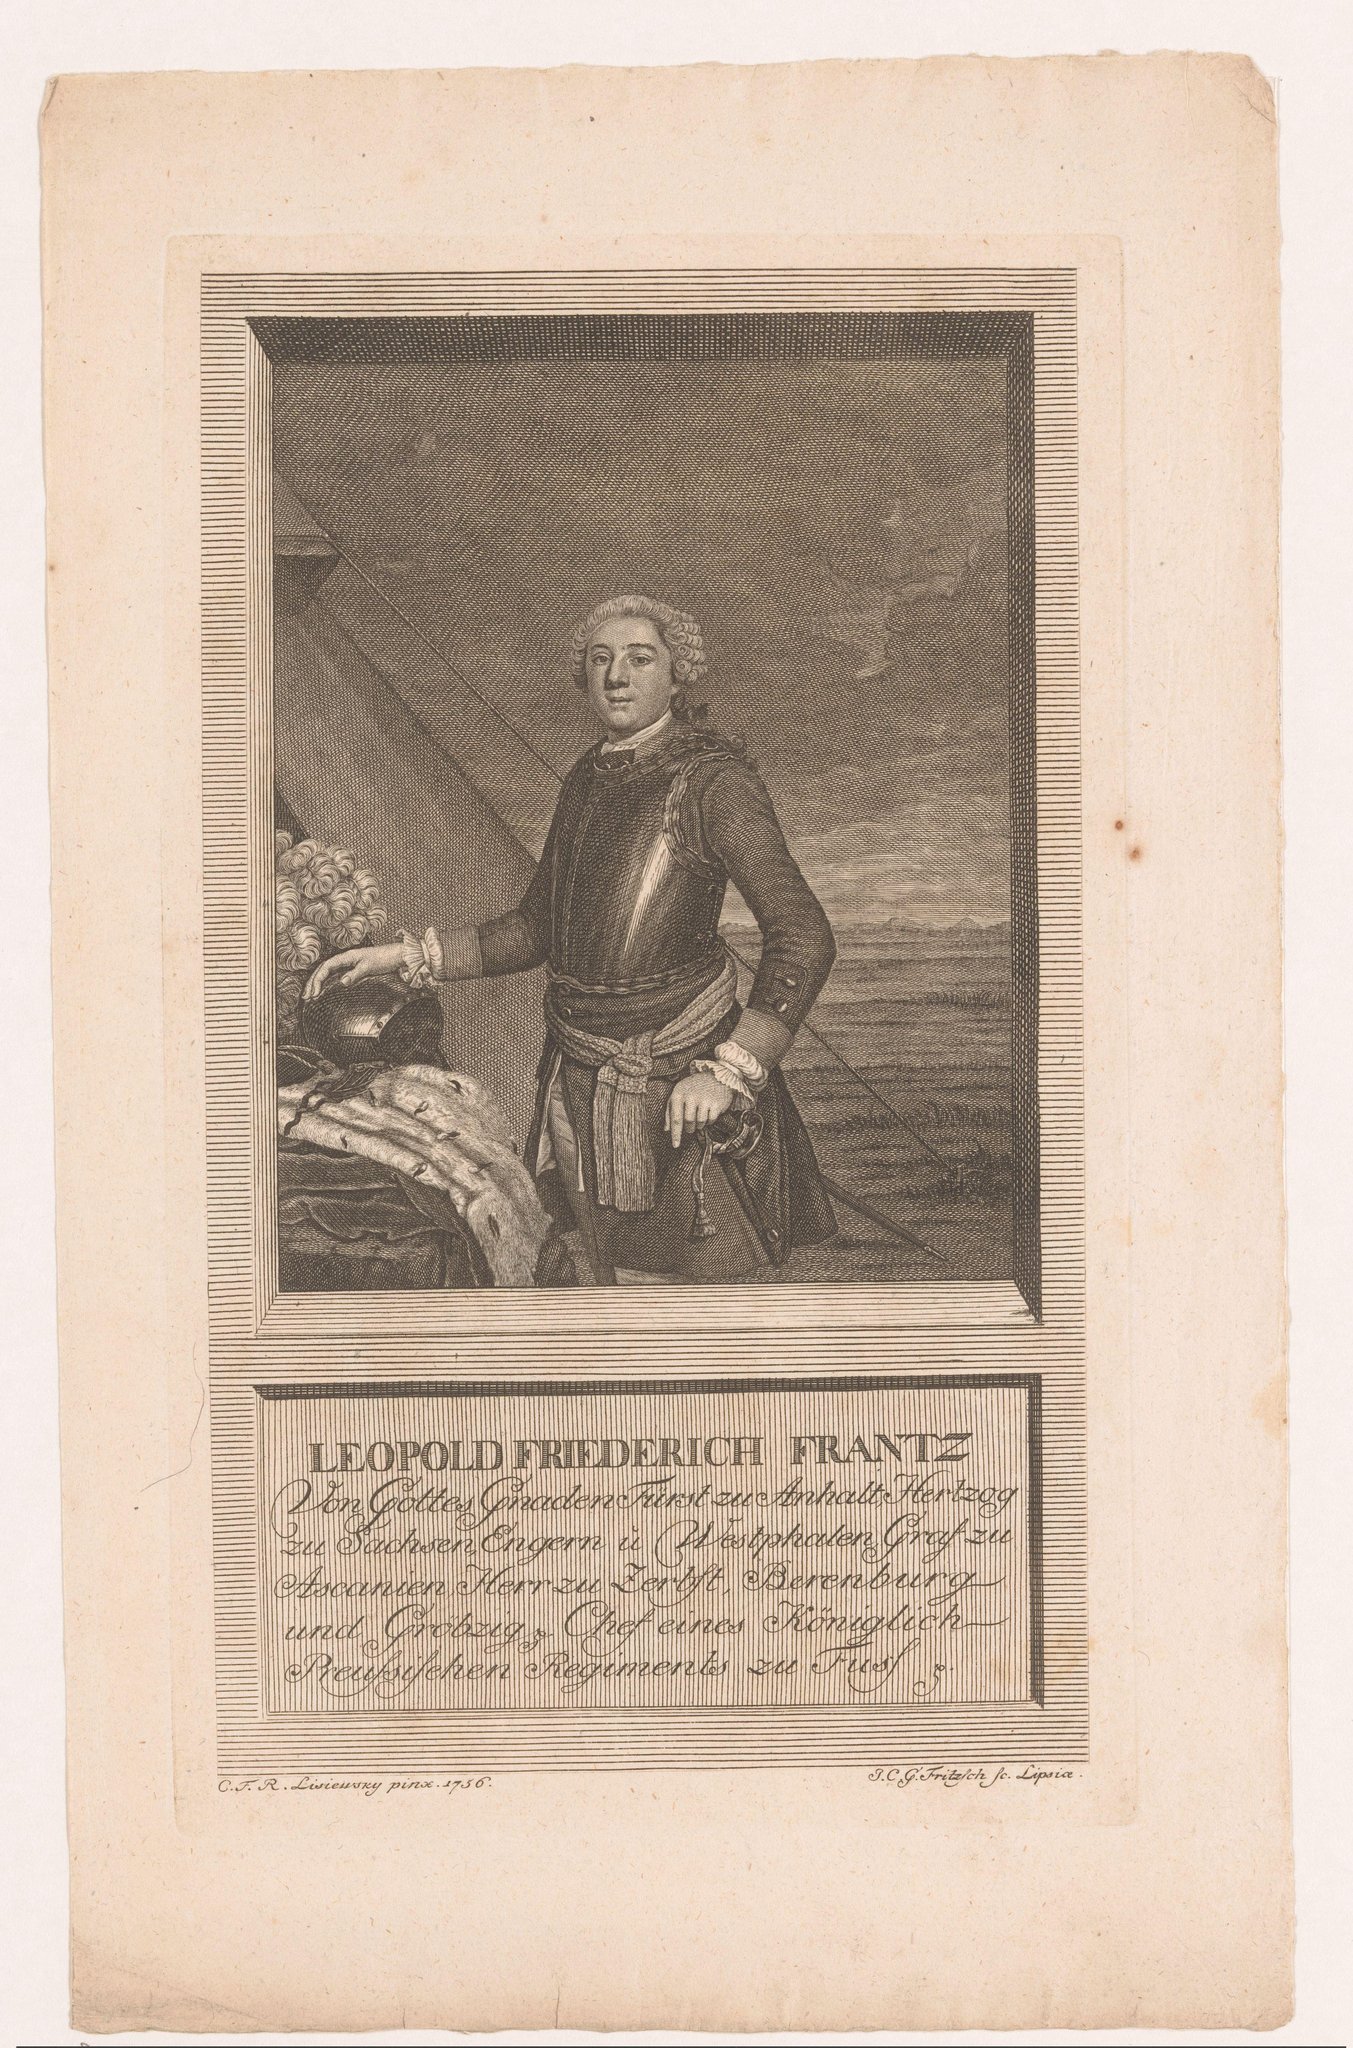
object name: print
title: Portret van Leopold III Friedrich Franz von Anhalt-Dessau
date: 1756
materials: paper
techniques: engraving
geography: leipzig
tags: leopold iii frederik frans van anhalt-dessau, helmet, (military) camp with tents, armour, historical persons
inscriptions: collector's mark: Lugt 2228